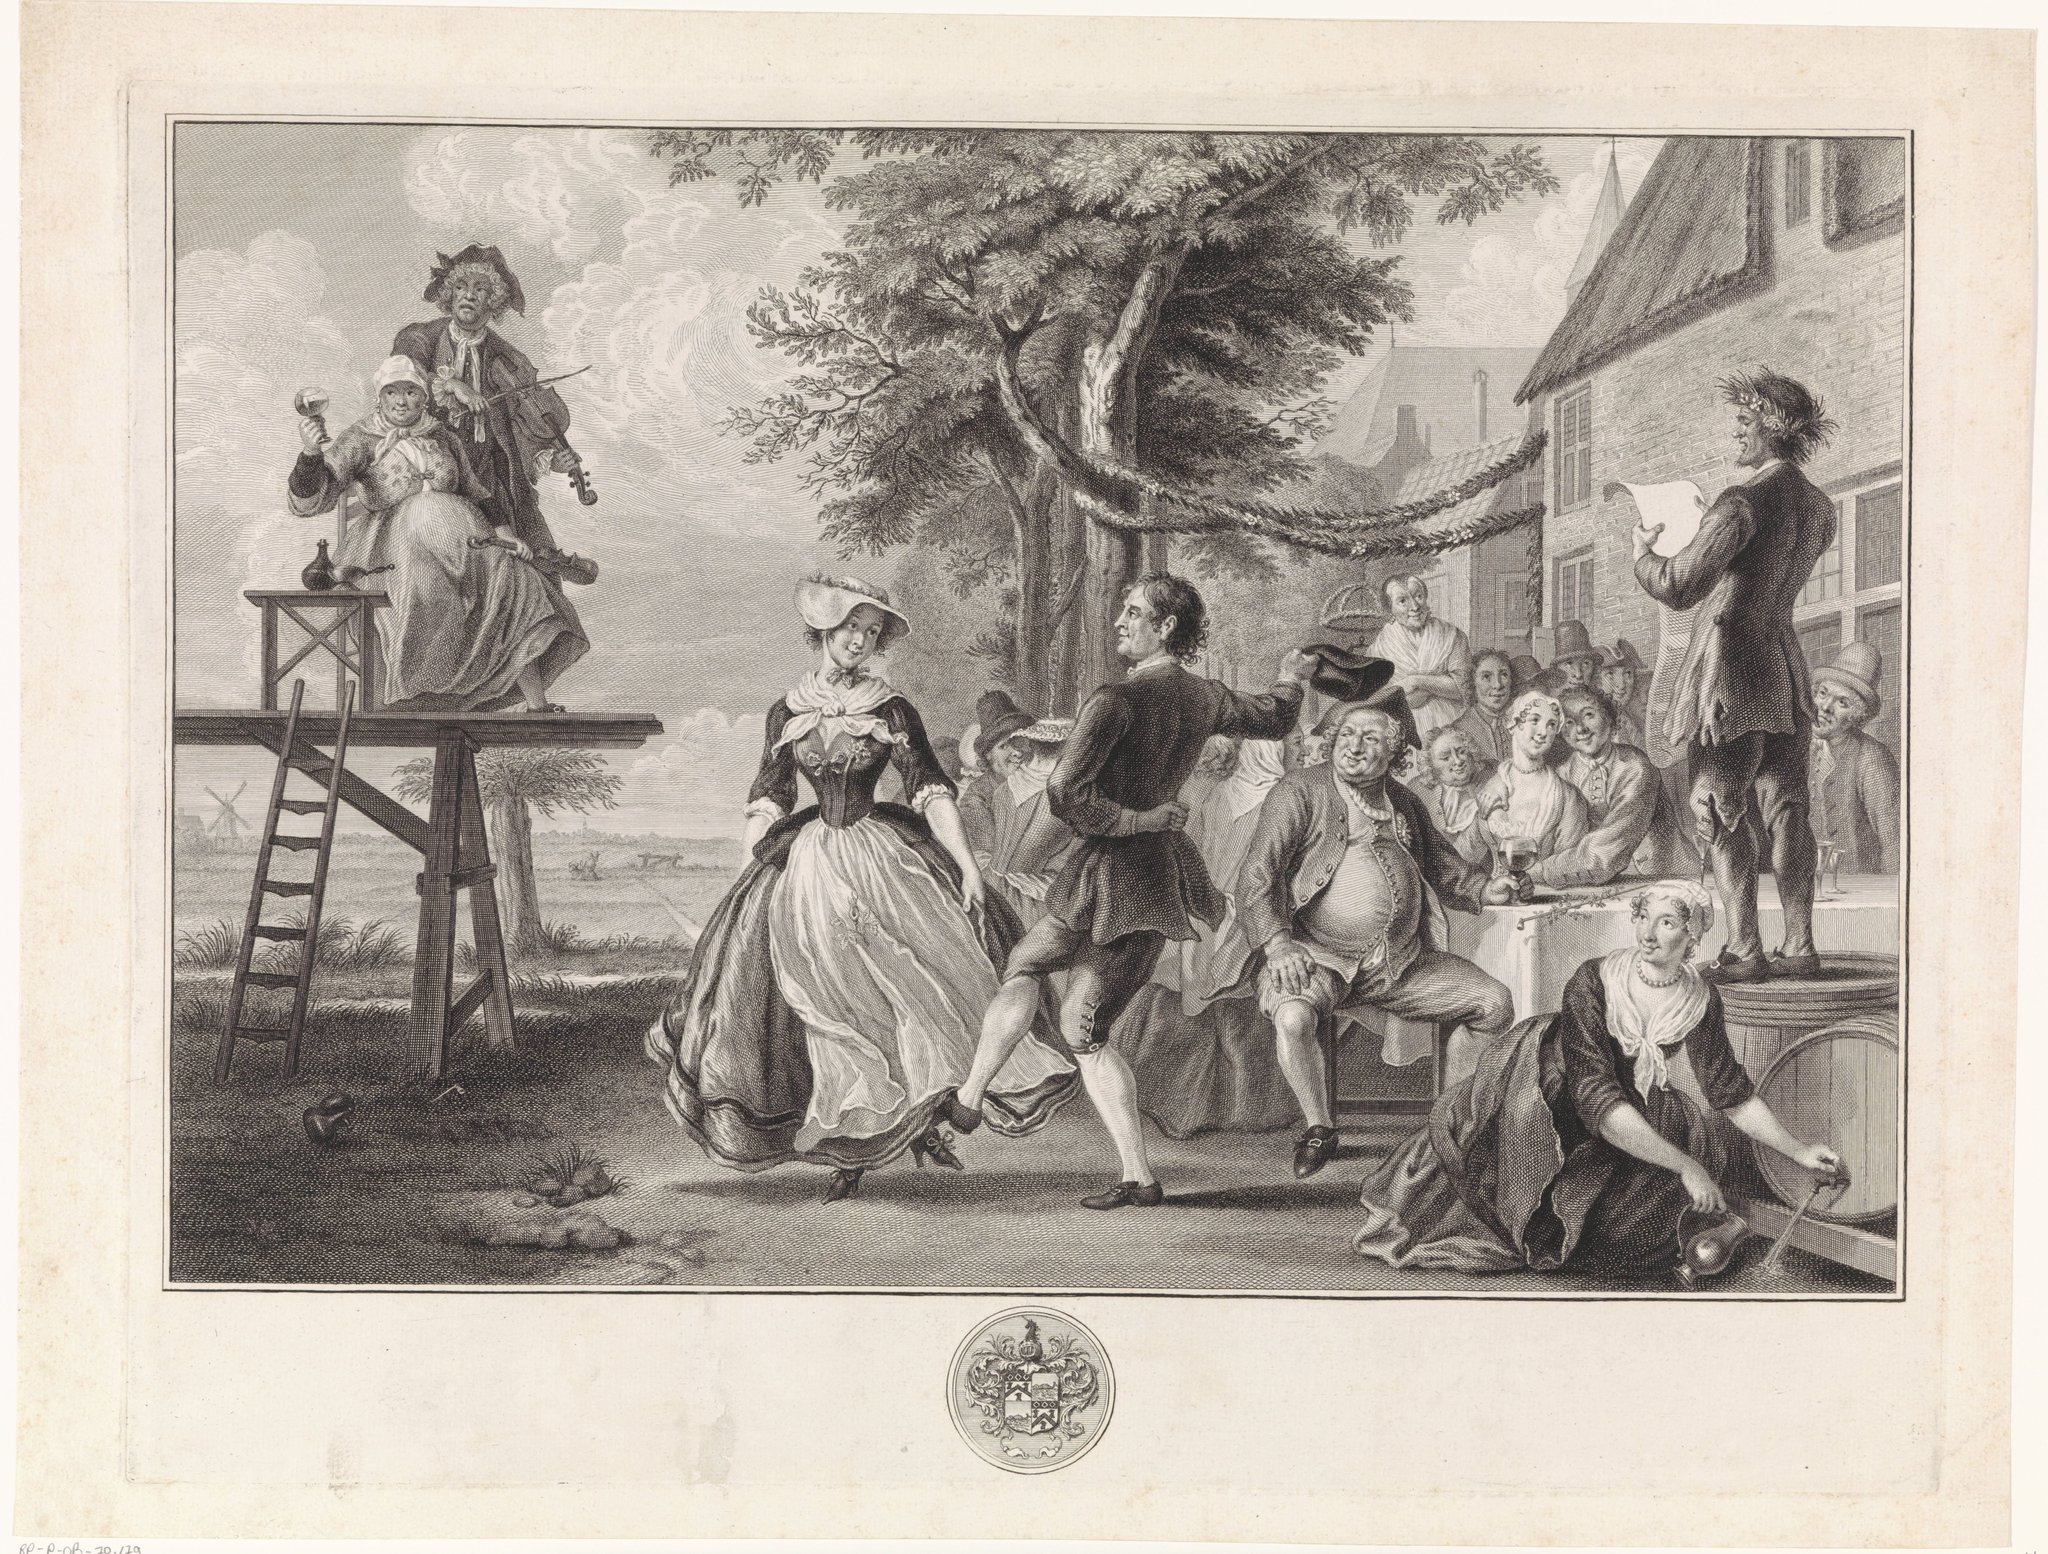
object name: print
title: Bruiloft van Cloris en Roosje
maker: pieter tanjé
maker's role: draughtsman, print maker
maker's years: 1706-1761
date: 1752-1761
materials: paper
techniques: engraving, etching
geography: amsterdam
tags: violin, fiddle, dancing at wedding feast - dd - out of doors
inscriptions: collector's mark: Lugt 2228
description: Cloris en Roosje dansen op hun bruiloft. Op de verhoging twee vioolspelers, van wie de vrouw het glas heft. Rechts de feestgangers en een man, die vanaf een ton een toespraak houdt. Onderaan in de marge het wapenschild van en een opdracht aan Jan Jacob de Bruyn, die het originele schilderij in zijn verzameling had. Scène uit het zangspel De bruiloft van Cloris en Roosje.